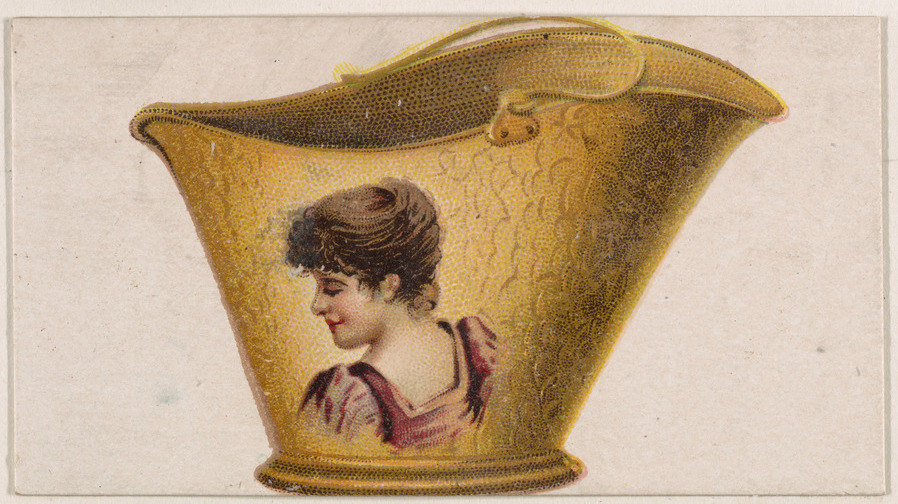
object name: print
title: Coal bucket, from the Novelties series (N228, Type 5) issued by Kinney Bros.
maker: kinney brothers tobacco company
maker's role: publisher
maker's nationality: american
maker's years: 1869-2011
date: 1889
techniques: color lithograph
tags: women,buckets